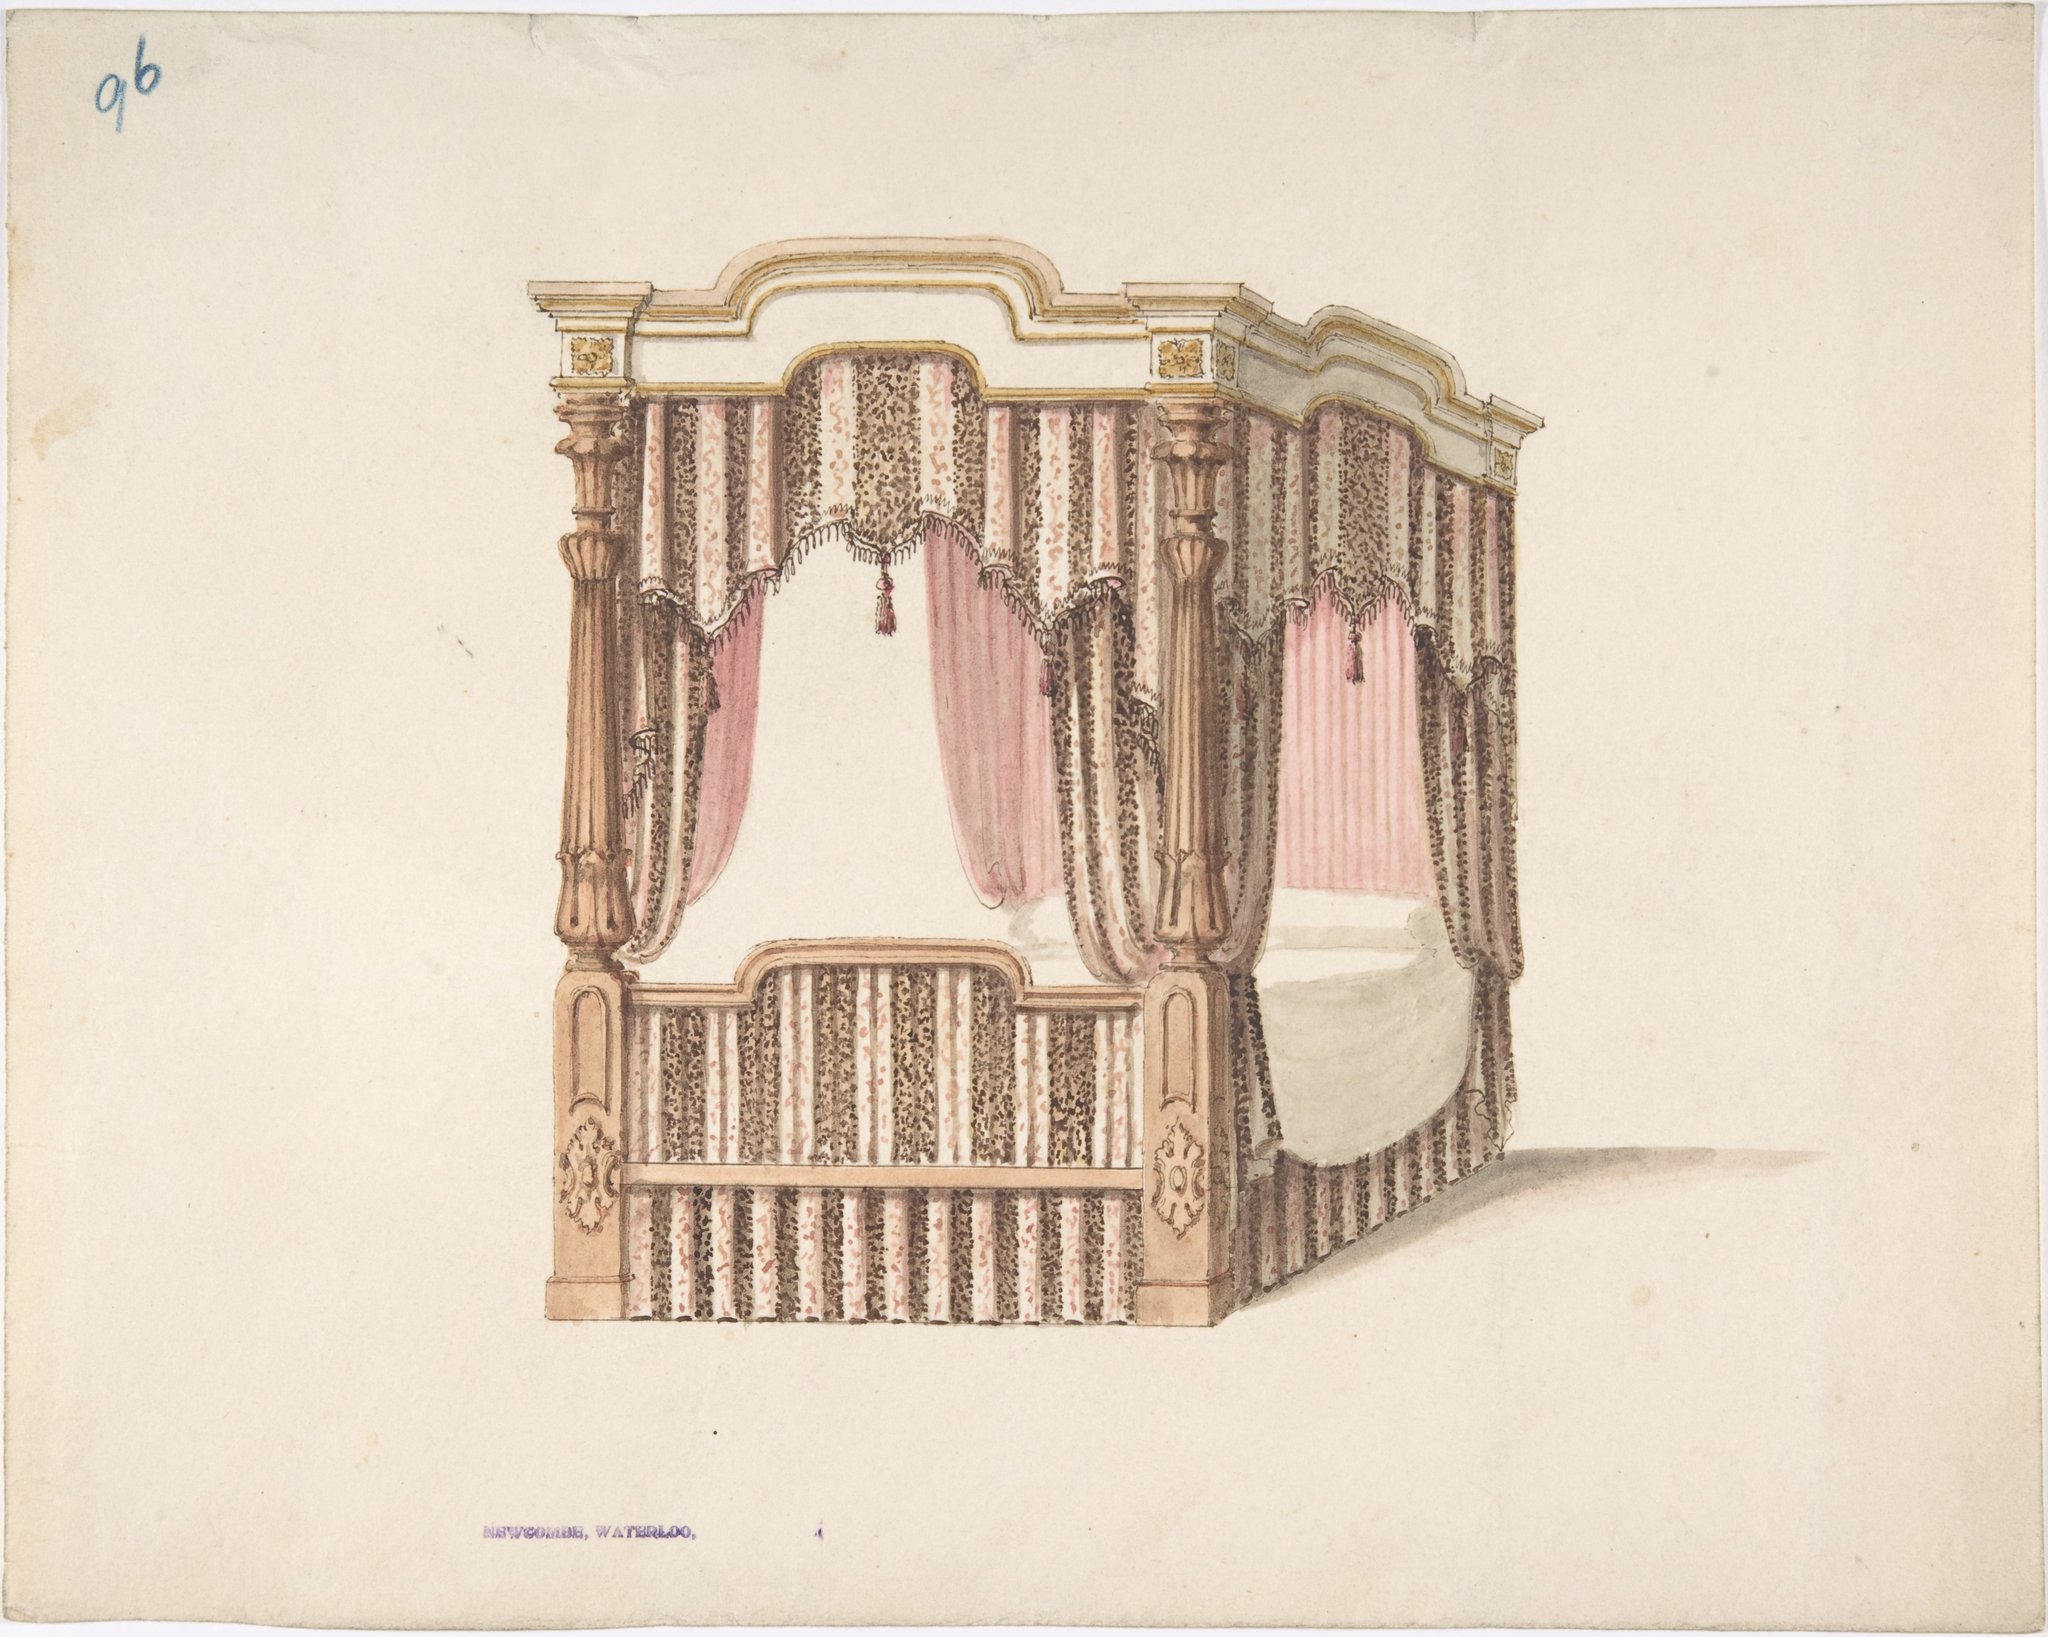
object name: drawing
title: Design for a Four-poster Bed with Pink, Brown and White Draperies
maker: anonymous, british, 19th century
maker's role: artist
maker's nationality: british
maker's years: 1800-1900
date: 1801-1833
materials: ink, watercolor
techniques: brush, pen, wash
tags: beds